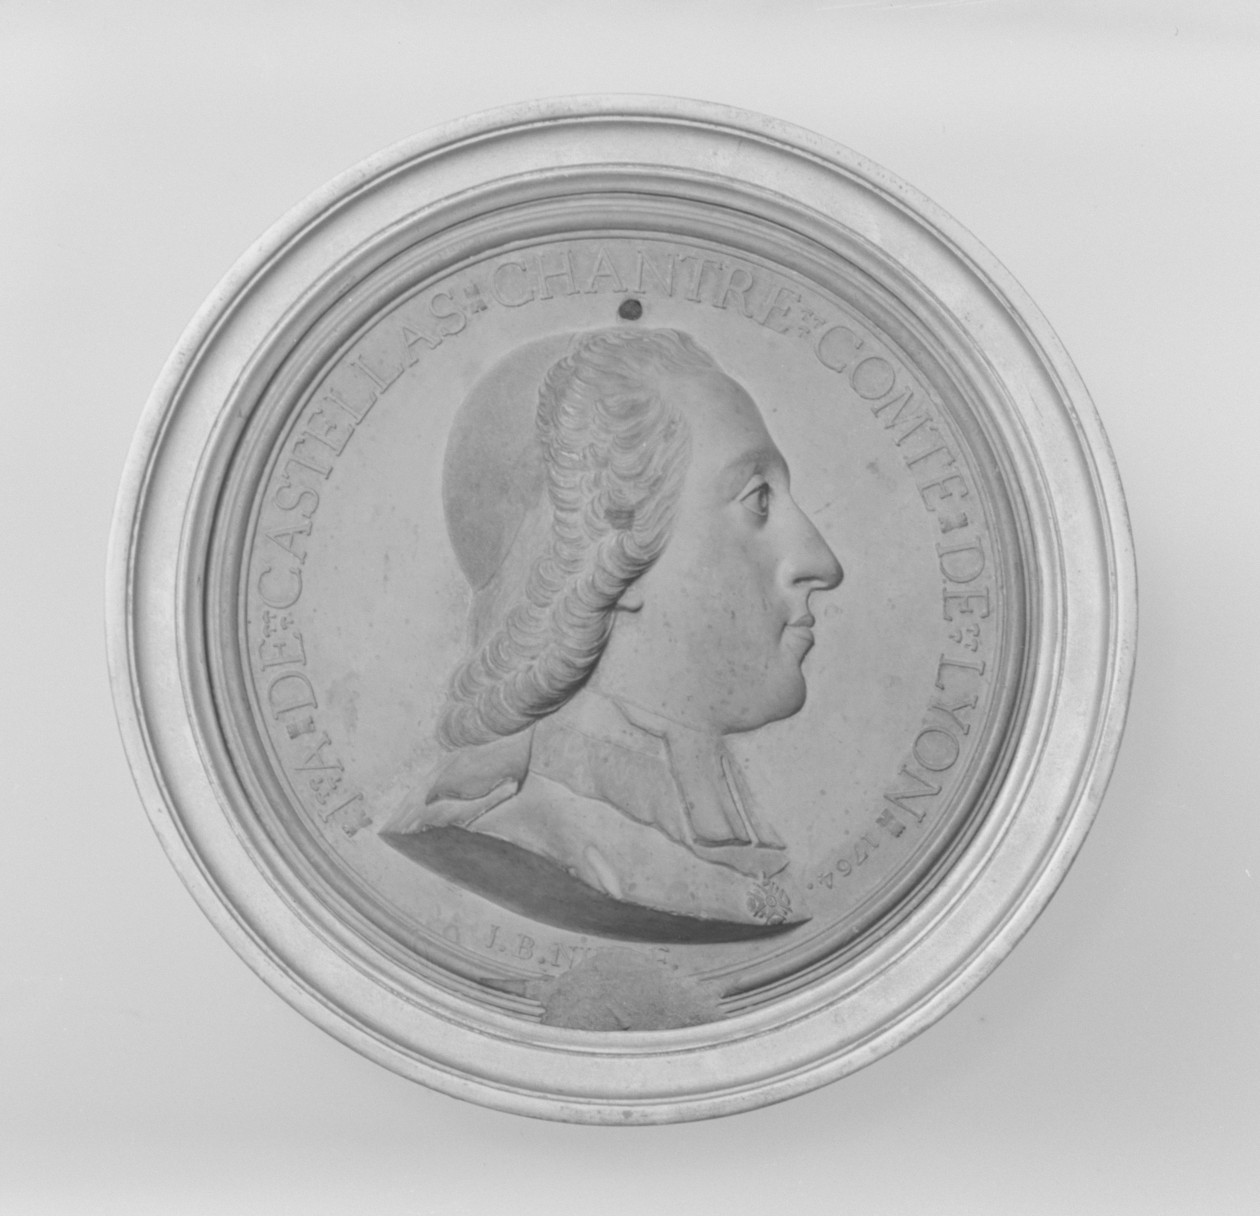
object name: medallion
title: Jean-Antoine de Castellas (1735–1802), churchman and cantor of Lyon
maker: jean-baptiste nini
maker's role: artist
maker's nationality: italian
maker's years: 1717-1786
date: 1764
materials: gilt, terracotta, wood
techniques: casting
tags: men